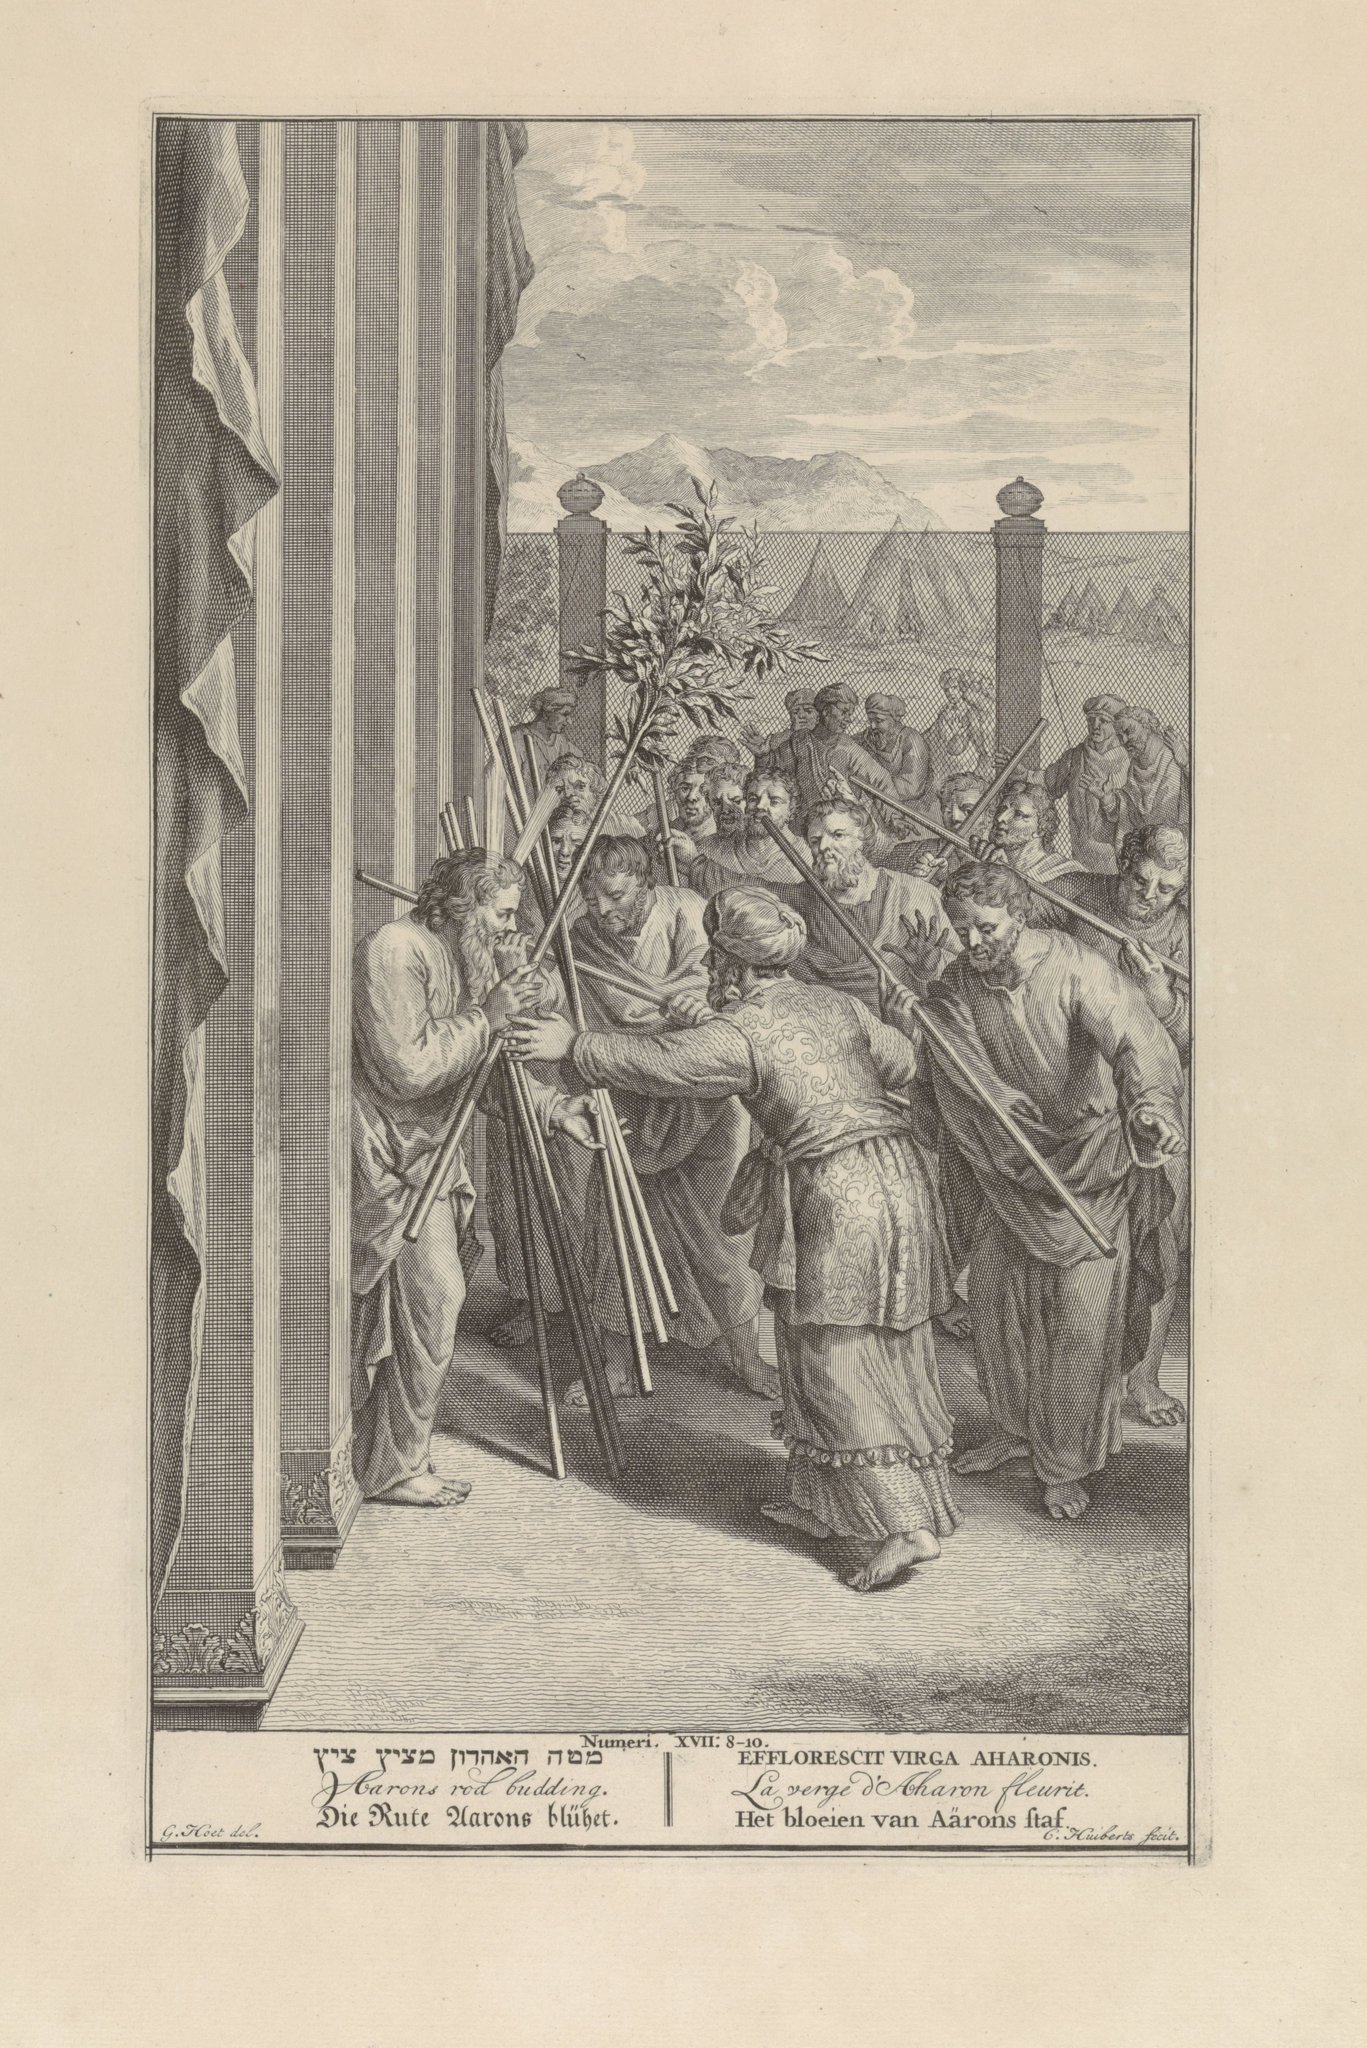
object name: print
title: Bloeiende staf van Aäron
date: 1720-1728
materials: paper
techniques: engraving, etching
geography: amsterdam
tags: aaron's rod has sprouted, flowered and produced ripe almonds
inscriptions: collector's mark: Lugt 2228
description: Prent gemaakt voor: Figures de la Bible. Amsterdam, Bernard Picart, 1720. Prent ook gebruikt in: Taferelen der voornaamste geschiedenissen van het Oude en Nieuwe Testament (...) door de vermaarde kunstenaars Hoet, Houbraken, en Picart getekent (...) en met beschrijvingen uitgebreid. Den Haag: Pieter de Hondt, 1728.